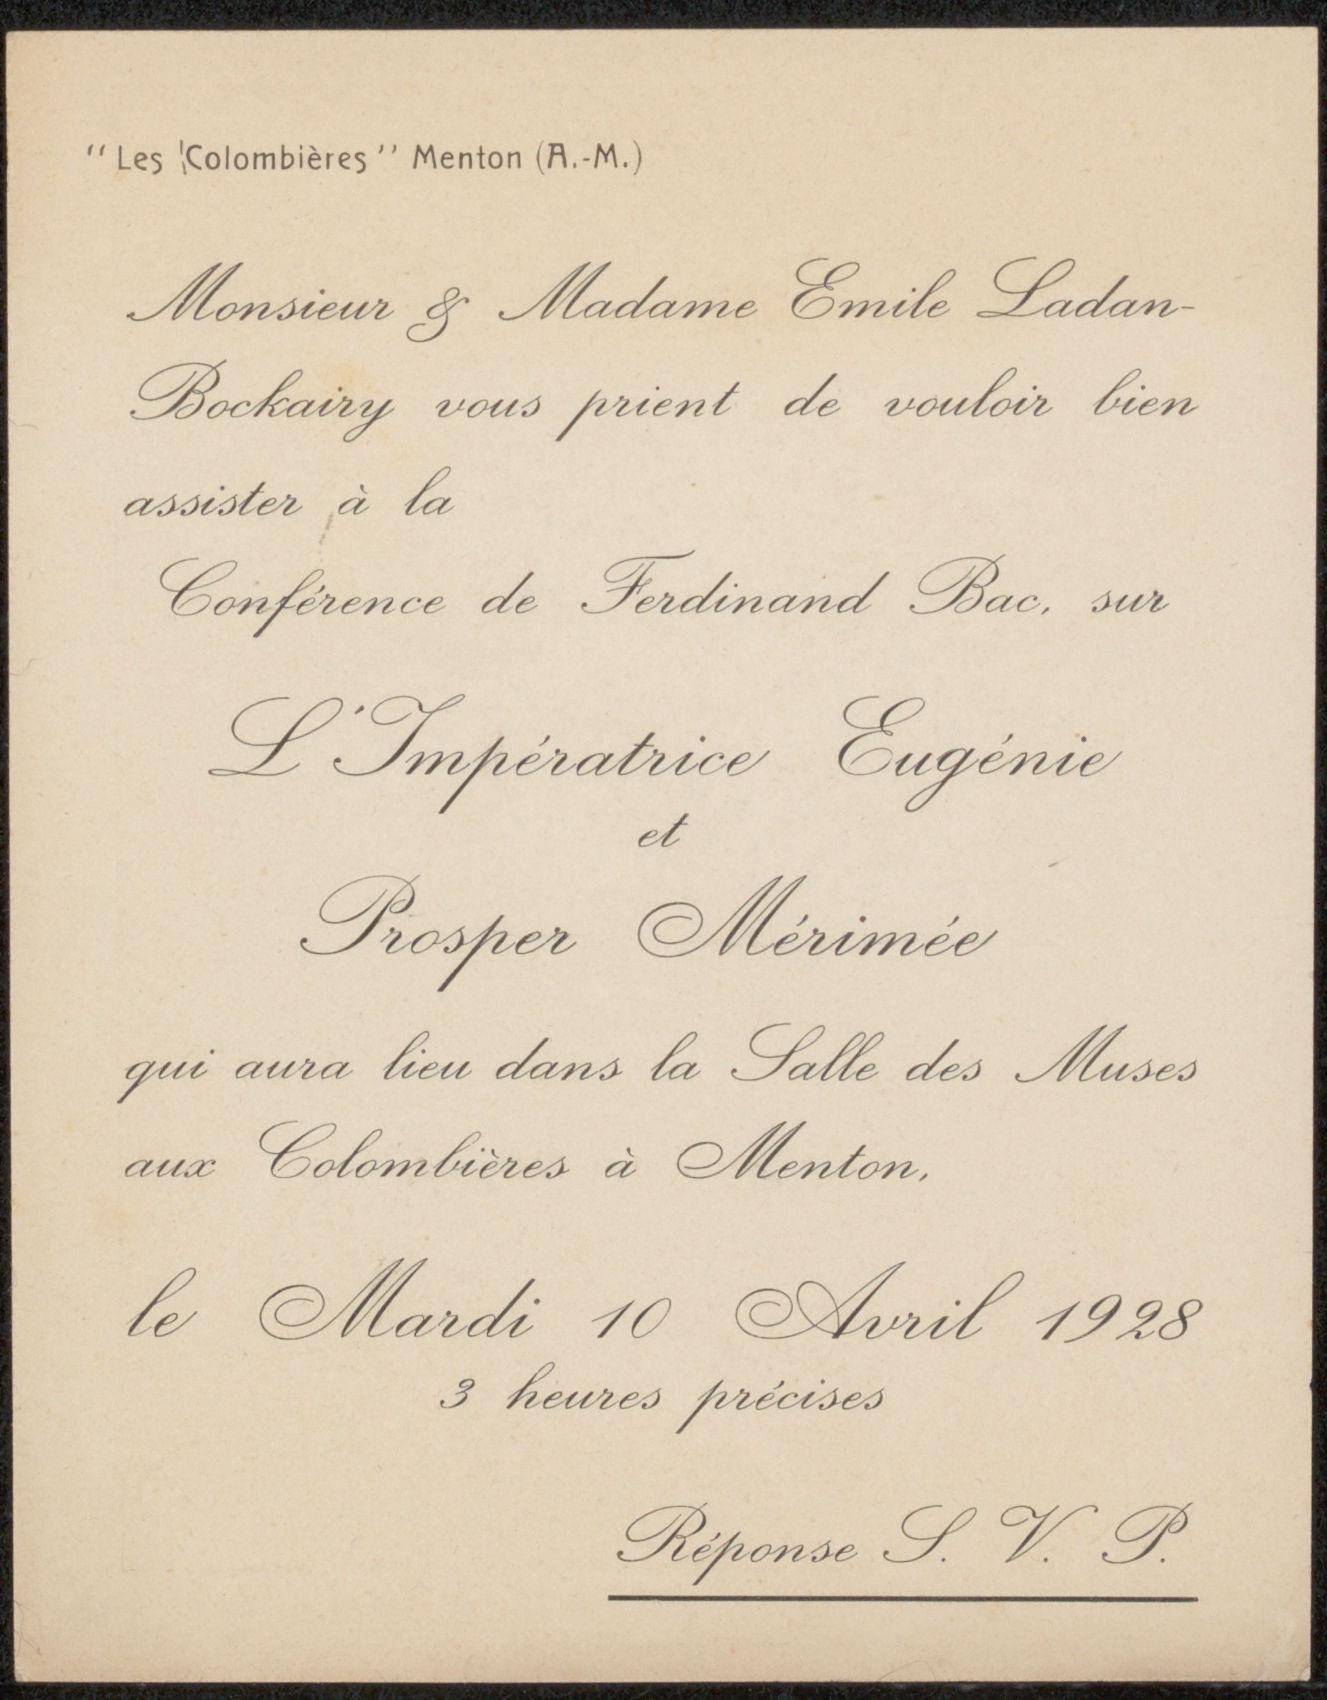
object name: invitation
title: Uitnodiging aan Philip Zilcken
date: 1928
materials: cardboard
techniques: printing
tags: paris, draughtsman, ferdinand-sigismund bac, the hague, painter, philip zilcken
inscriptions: collector's mark: ‘RPK’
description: Uitnodiging tot het leveren van een bijdrage aan de conferentie van Ferdinand-Sigismund Bac in Menton.